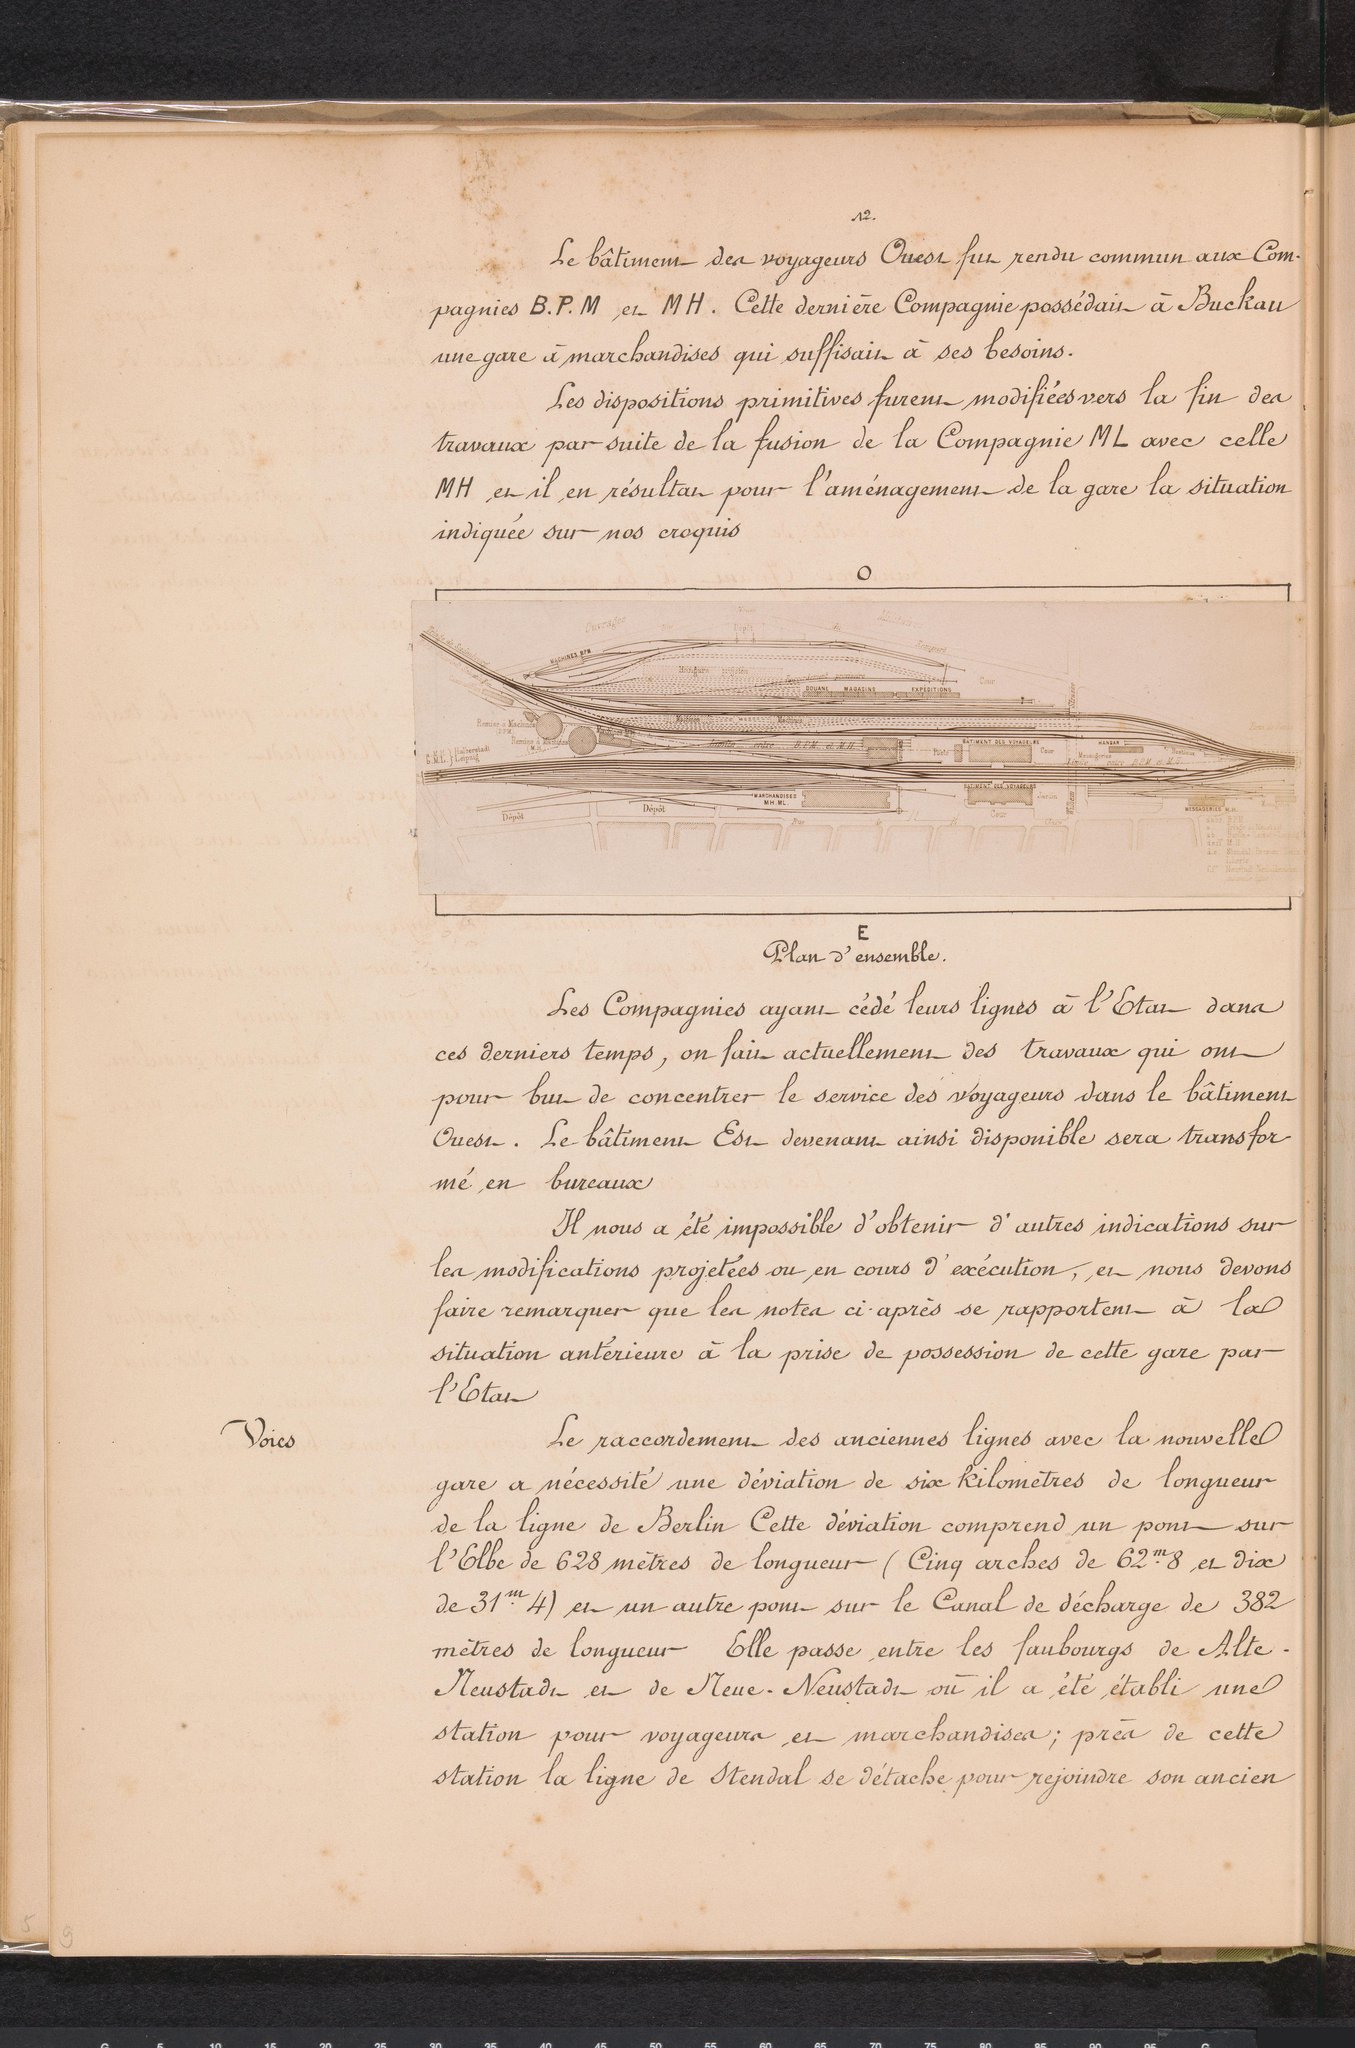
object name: reproduction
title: Fotoreproductie van een plattegrond van de spoorwegen te Maagdenburg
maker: Anonymous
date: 1874-1884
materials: photographic support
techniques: albumen print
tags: maps, atlases, railway, train